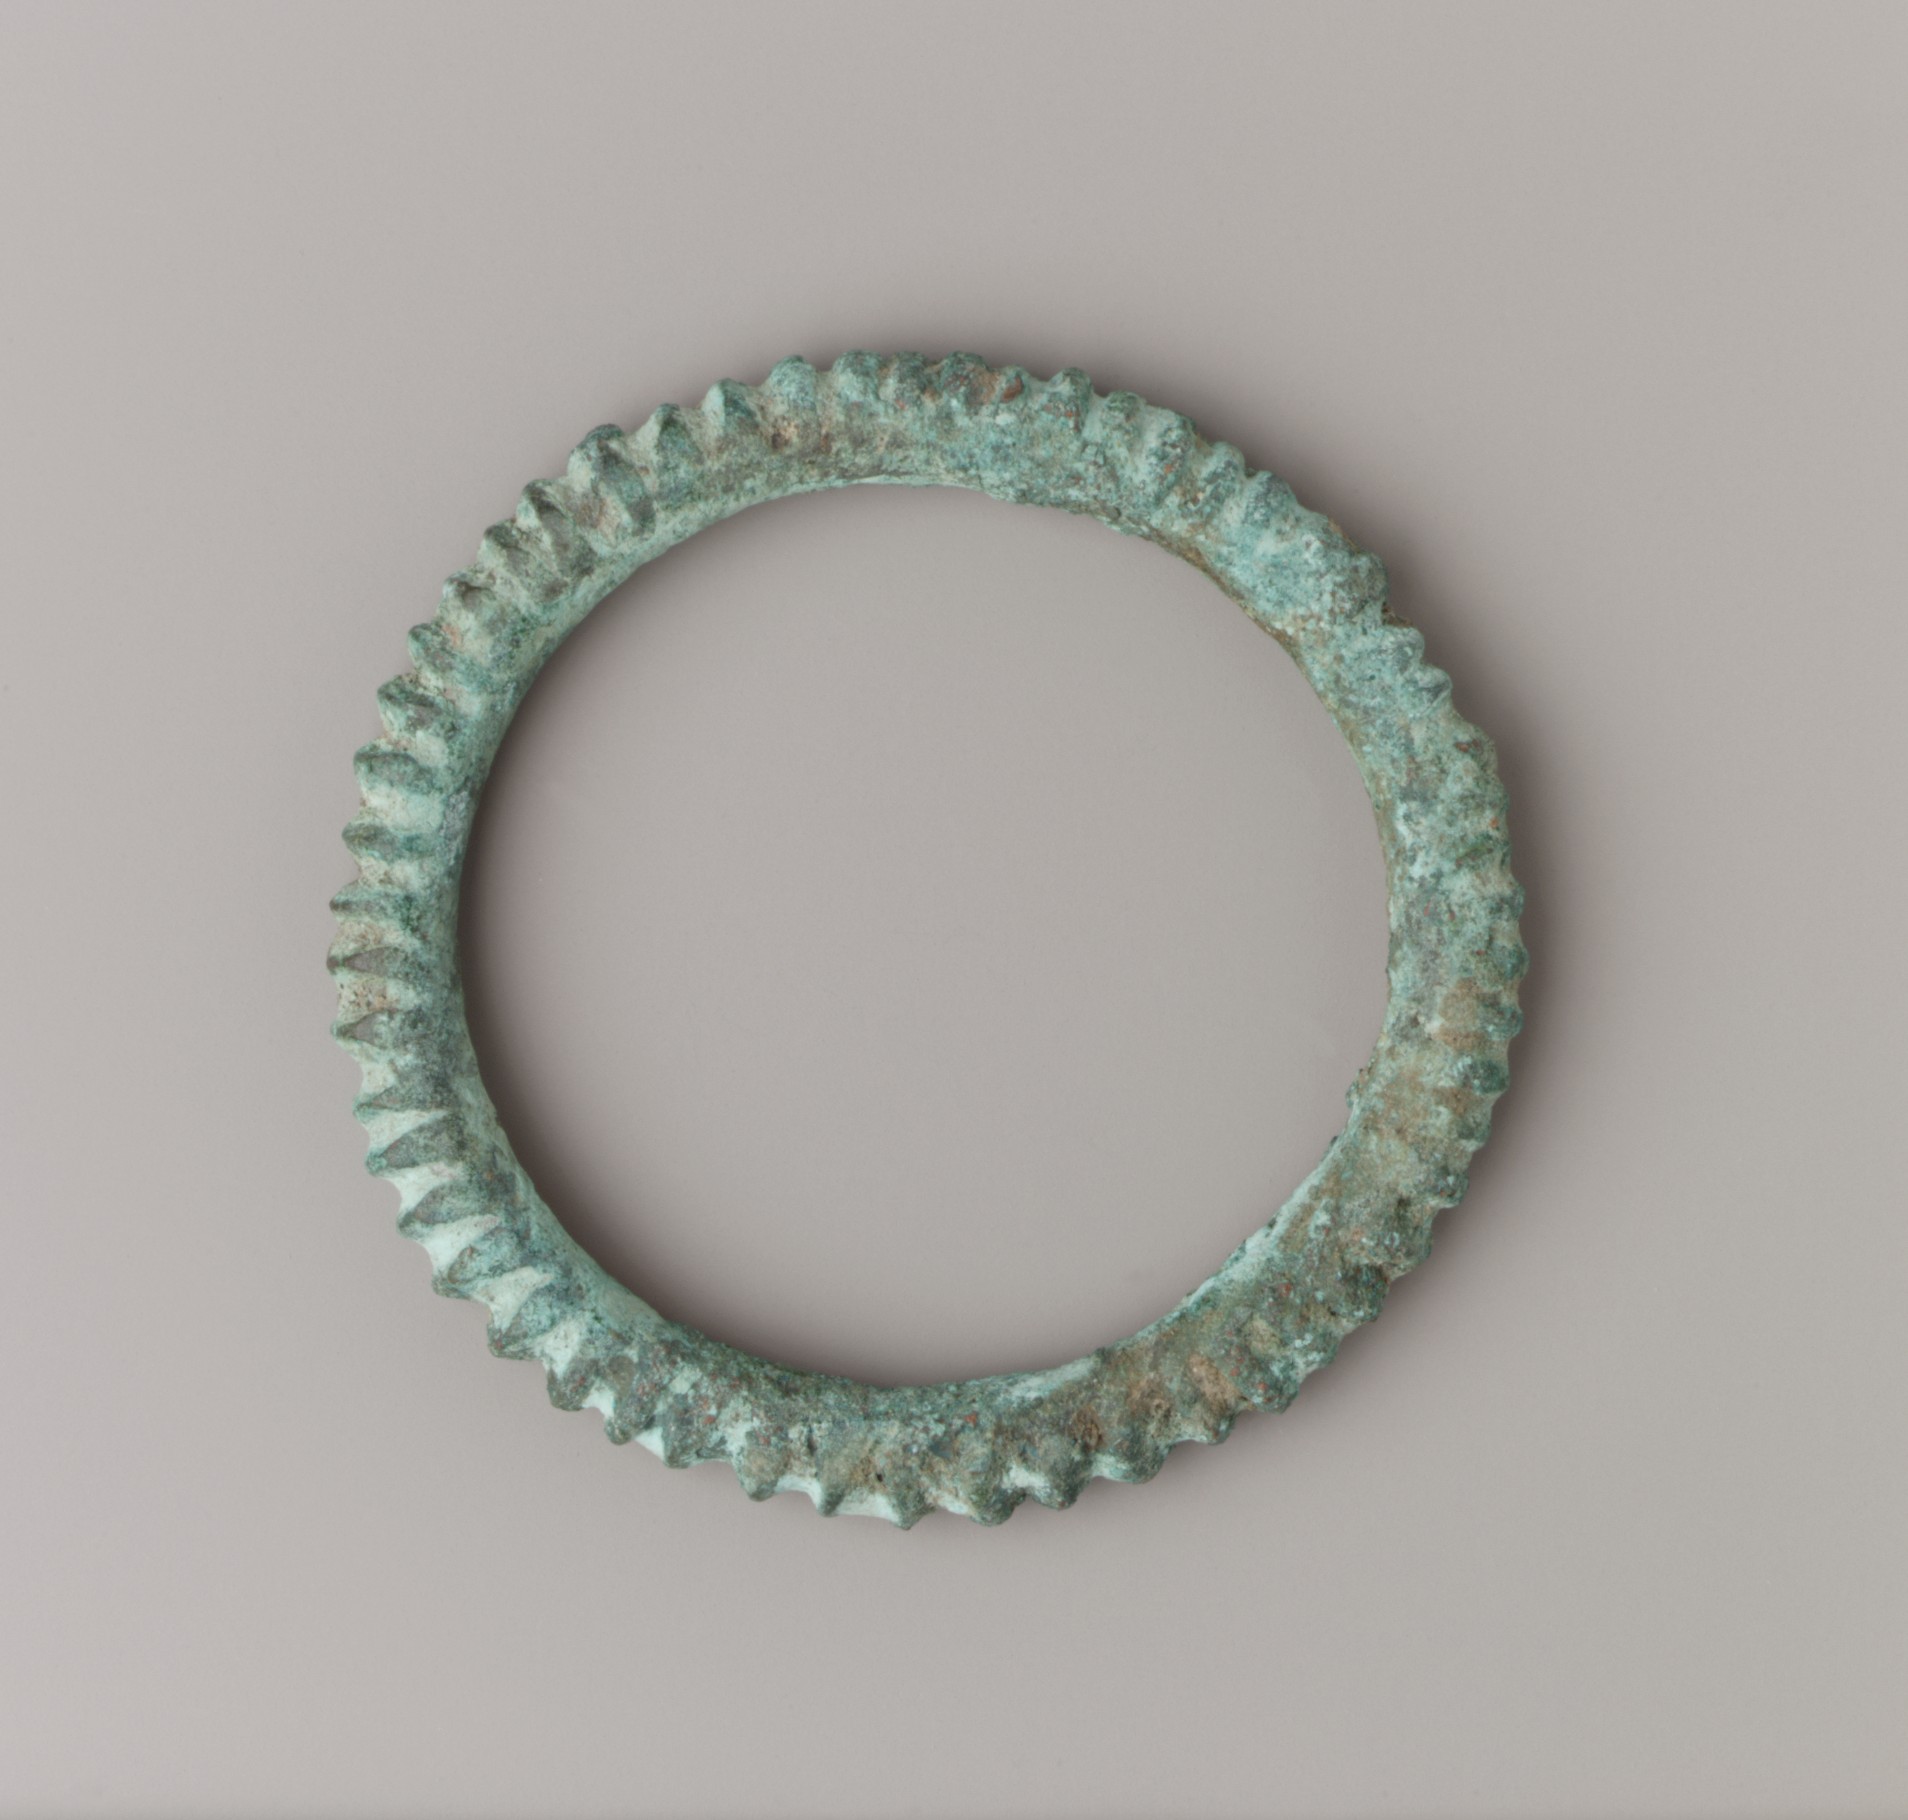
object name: bracelet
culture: middle niger civilization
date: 1001-1600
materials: copper alloy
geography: mali